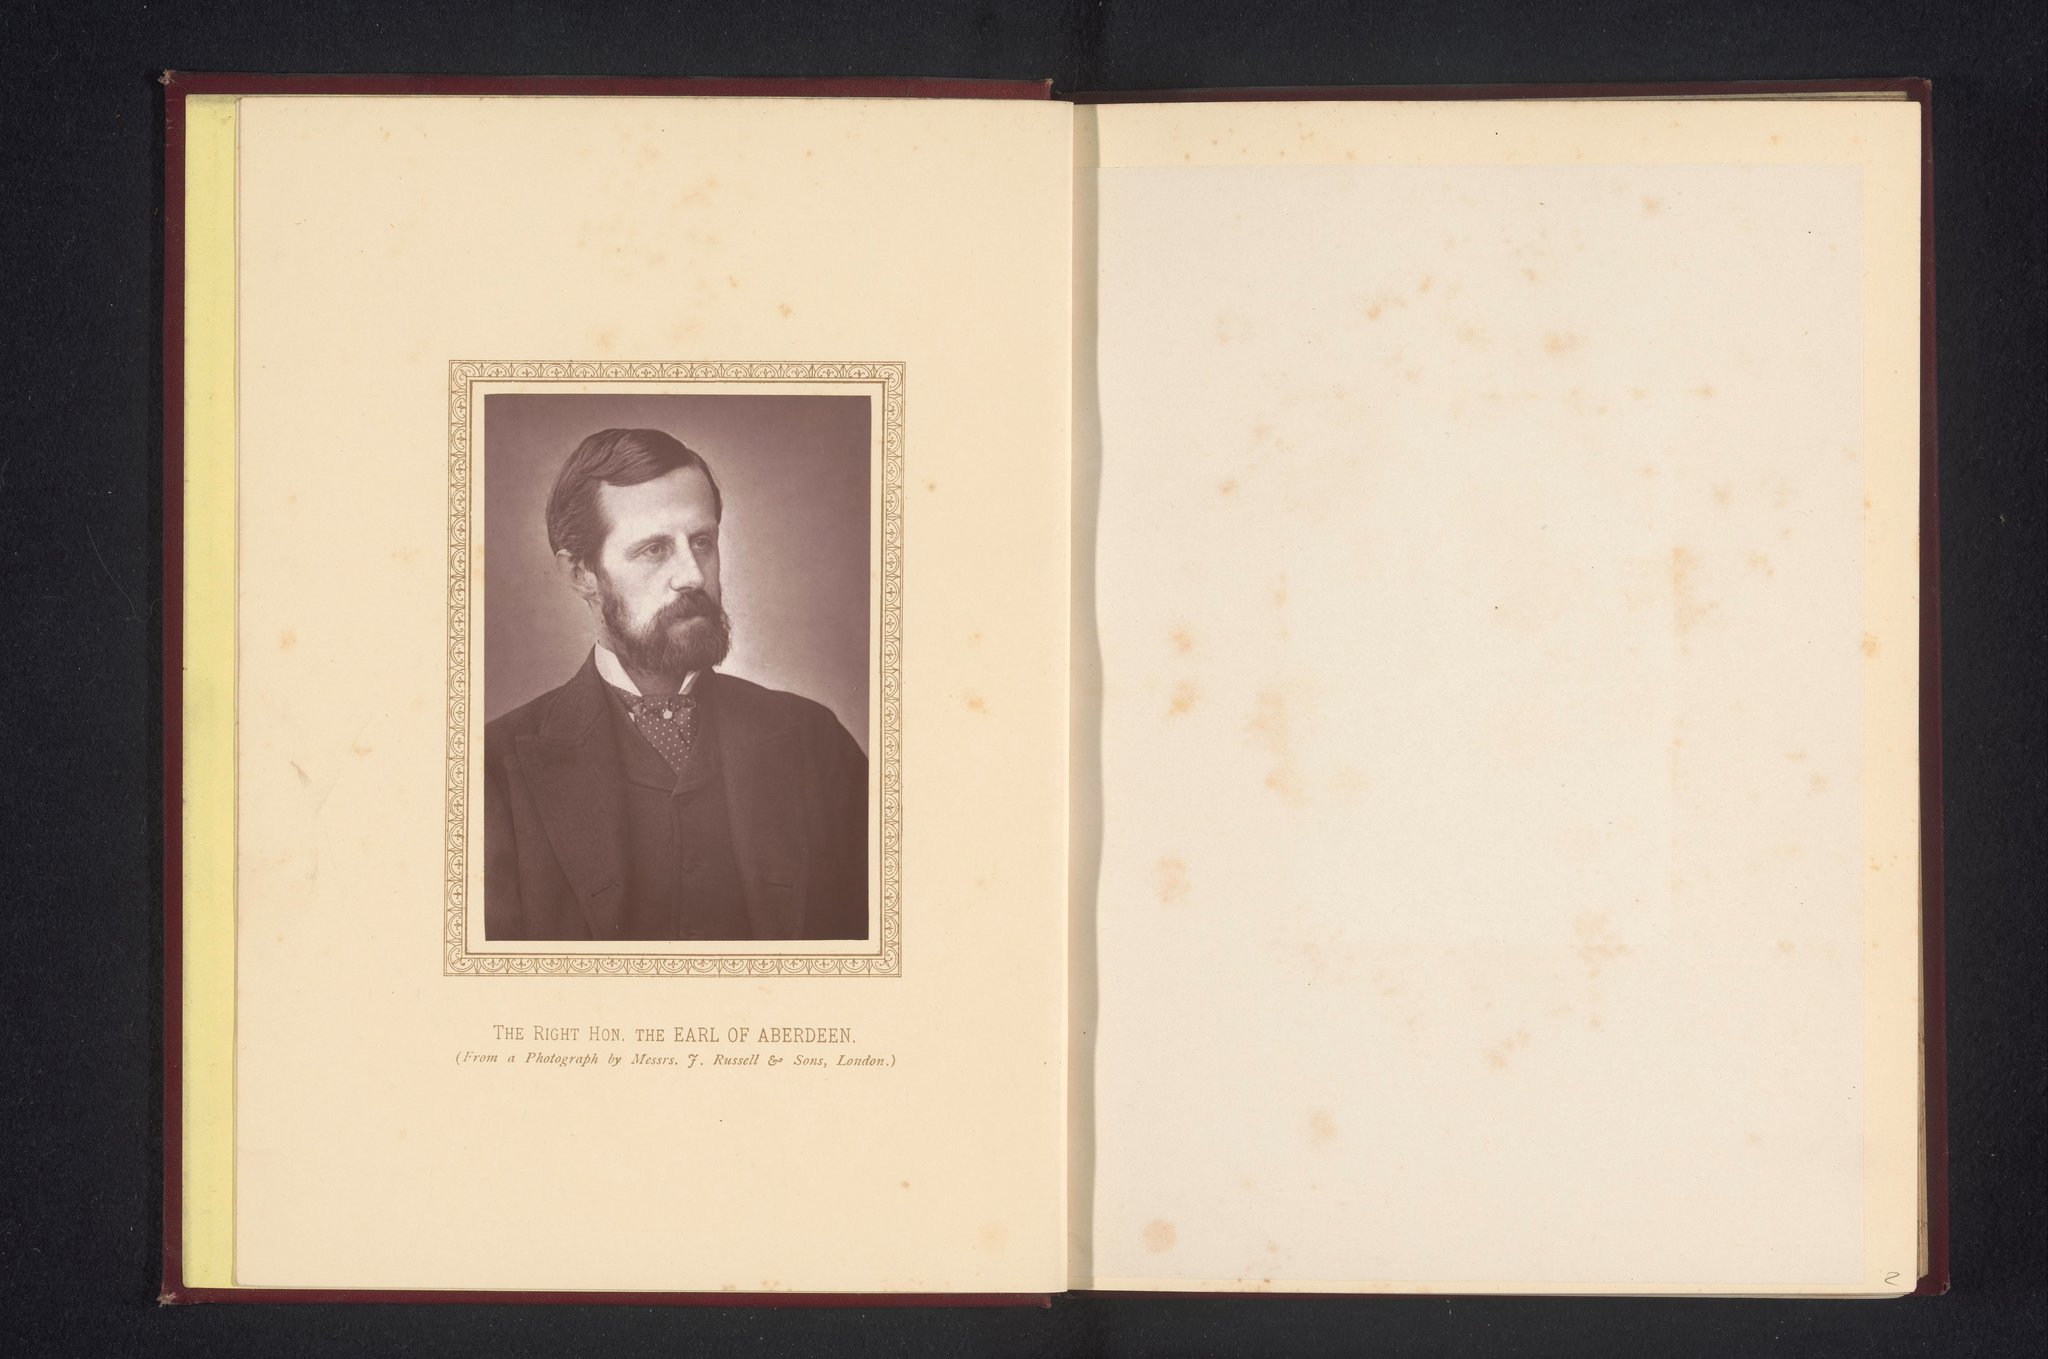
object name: photomechanical print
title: The right hon. the Earl of Aberdeen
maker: Anonymous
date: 1875-1880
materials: paper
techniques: woodburytype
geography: london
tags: politician, e.g. party leader